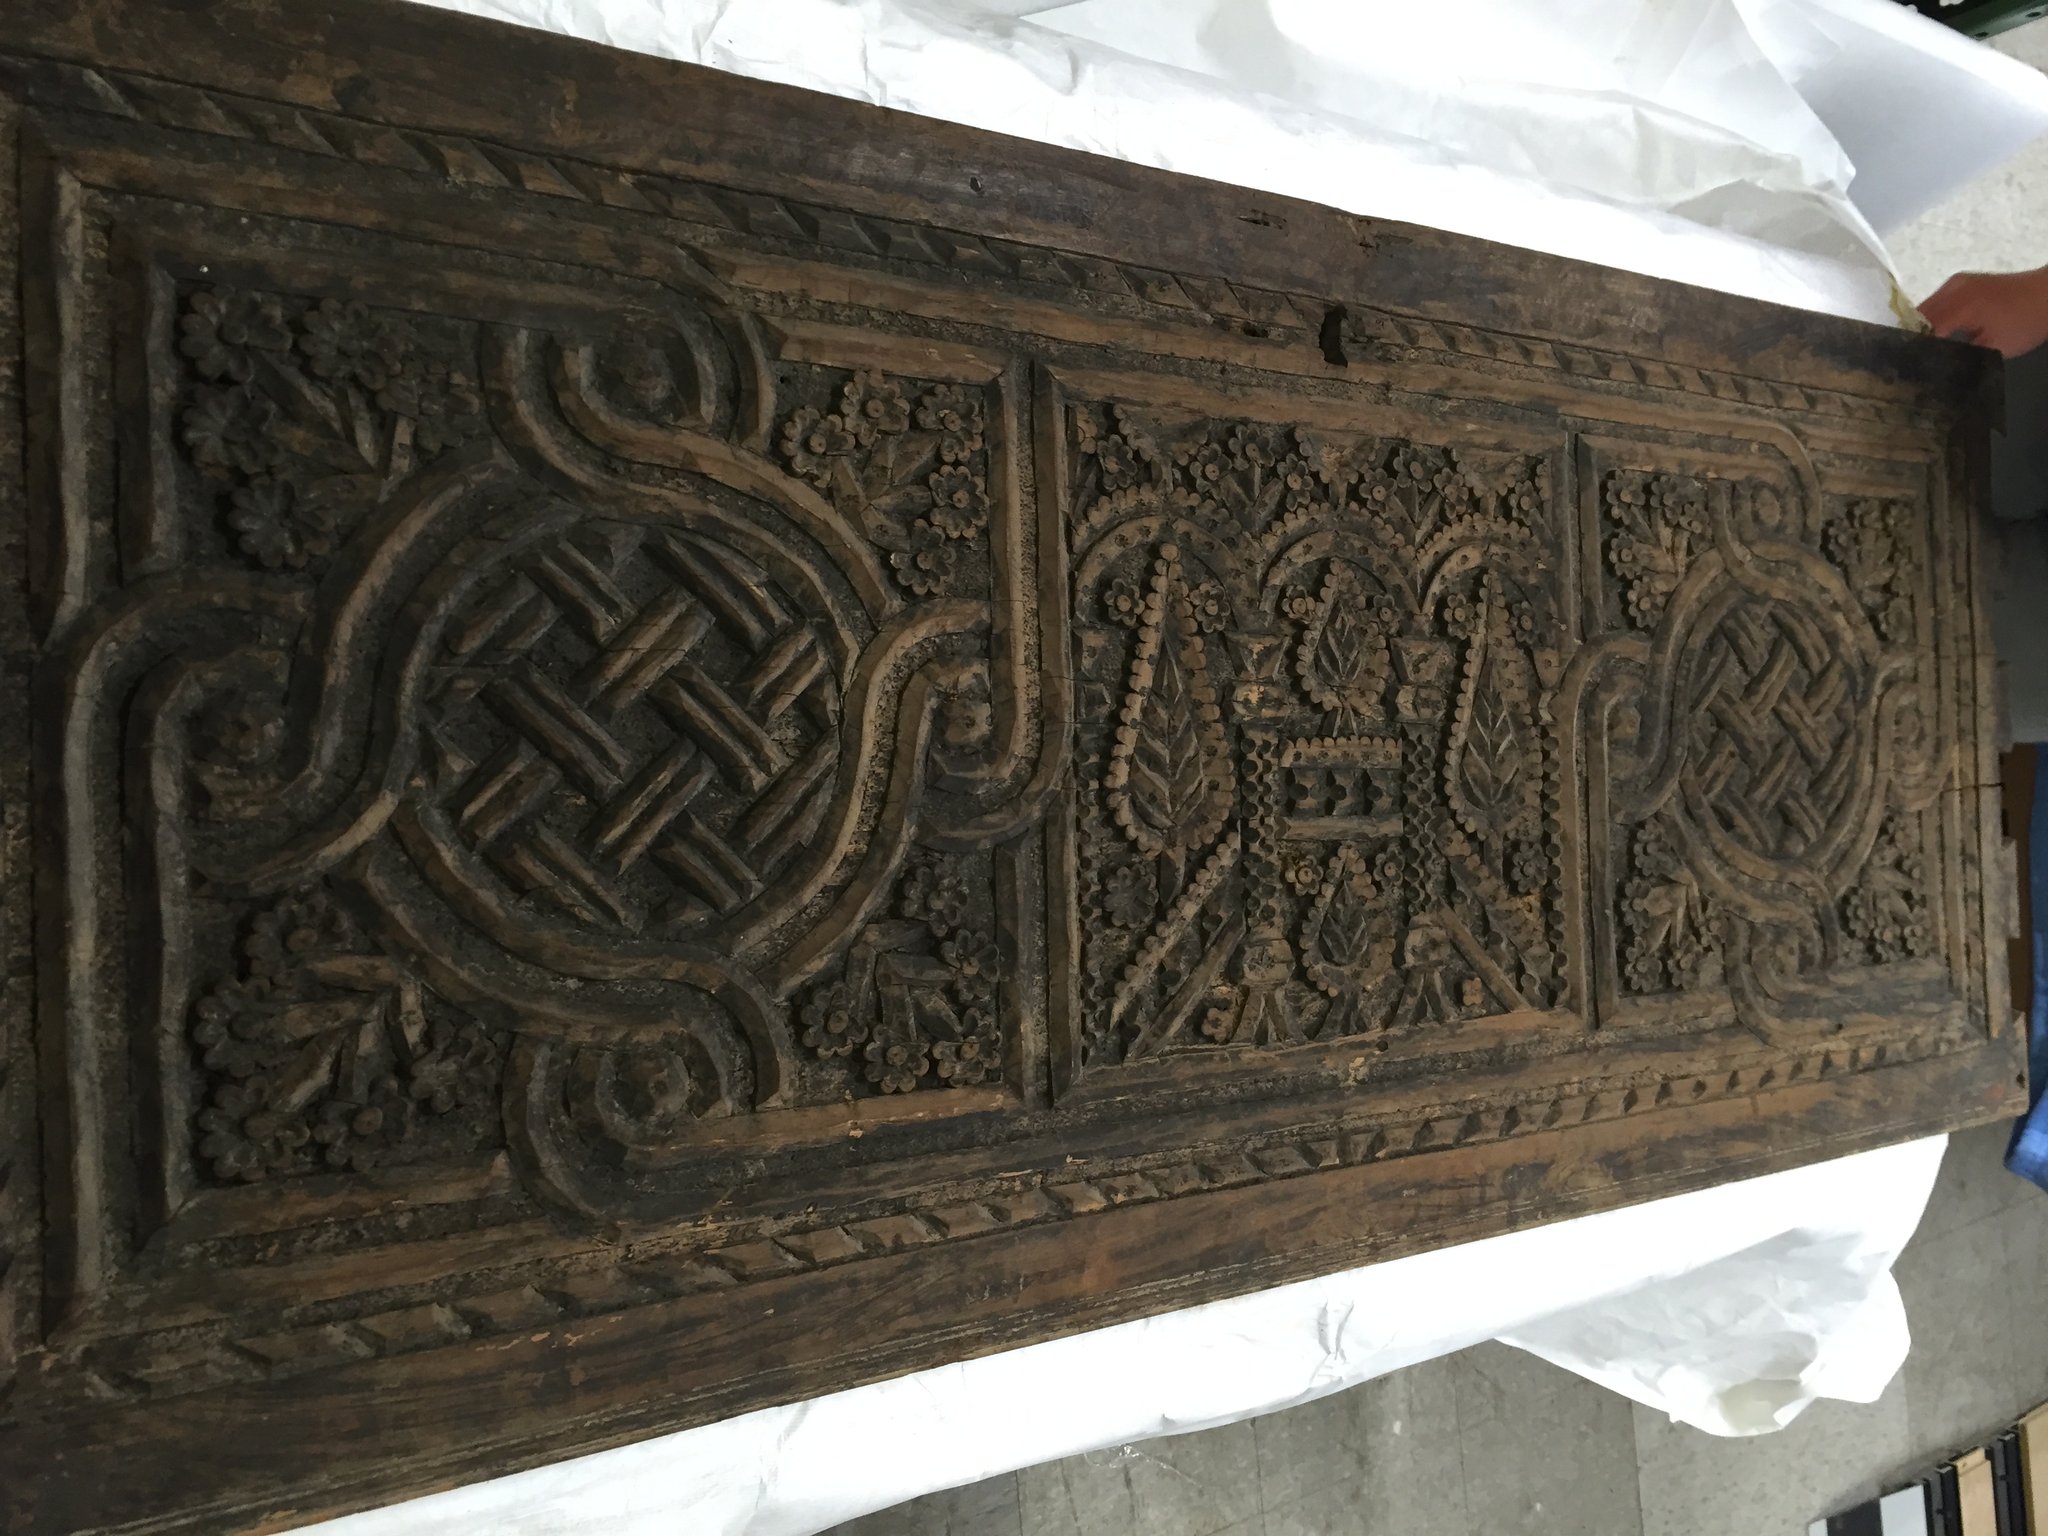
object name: chest front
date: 1701-1800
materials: wood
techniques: carving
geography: syria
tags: leaves,chests